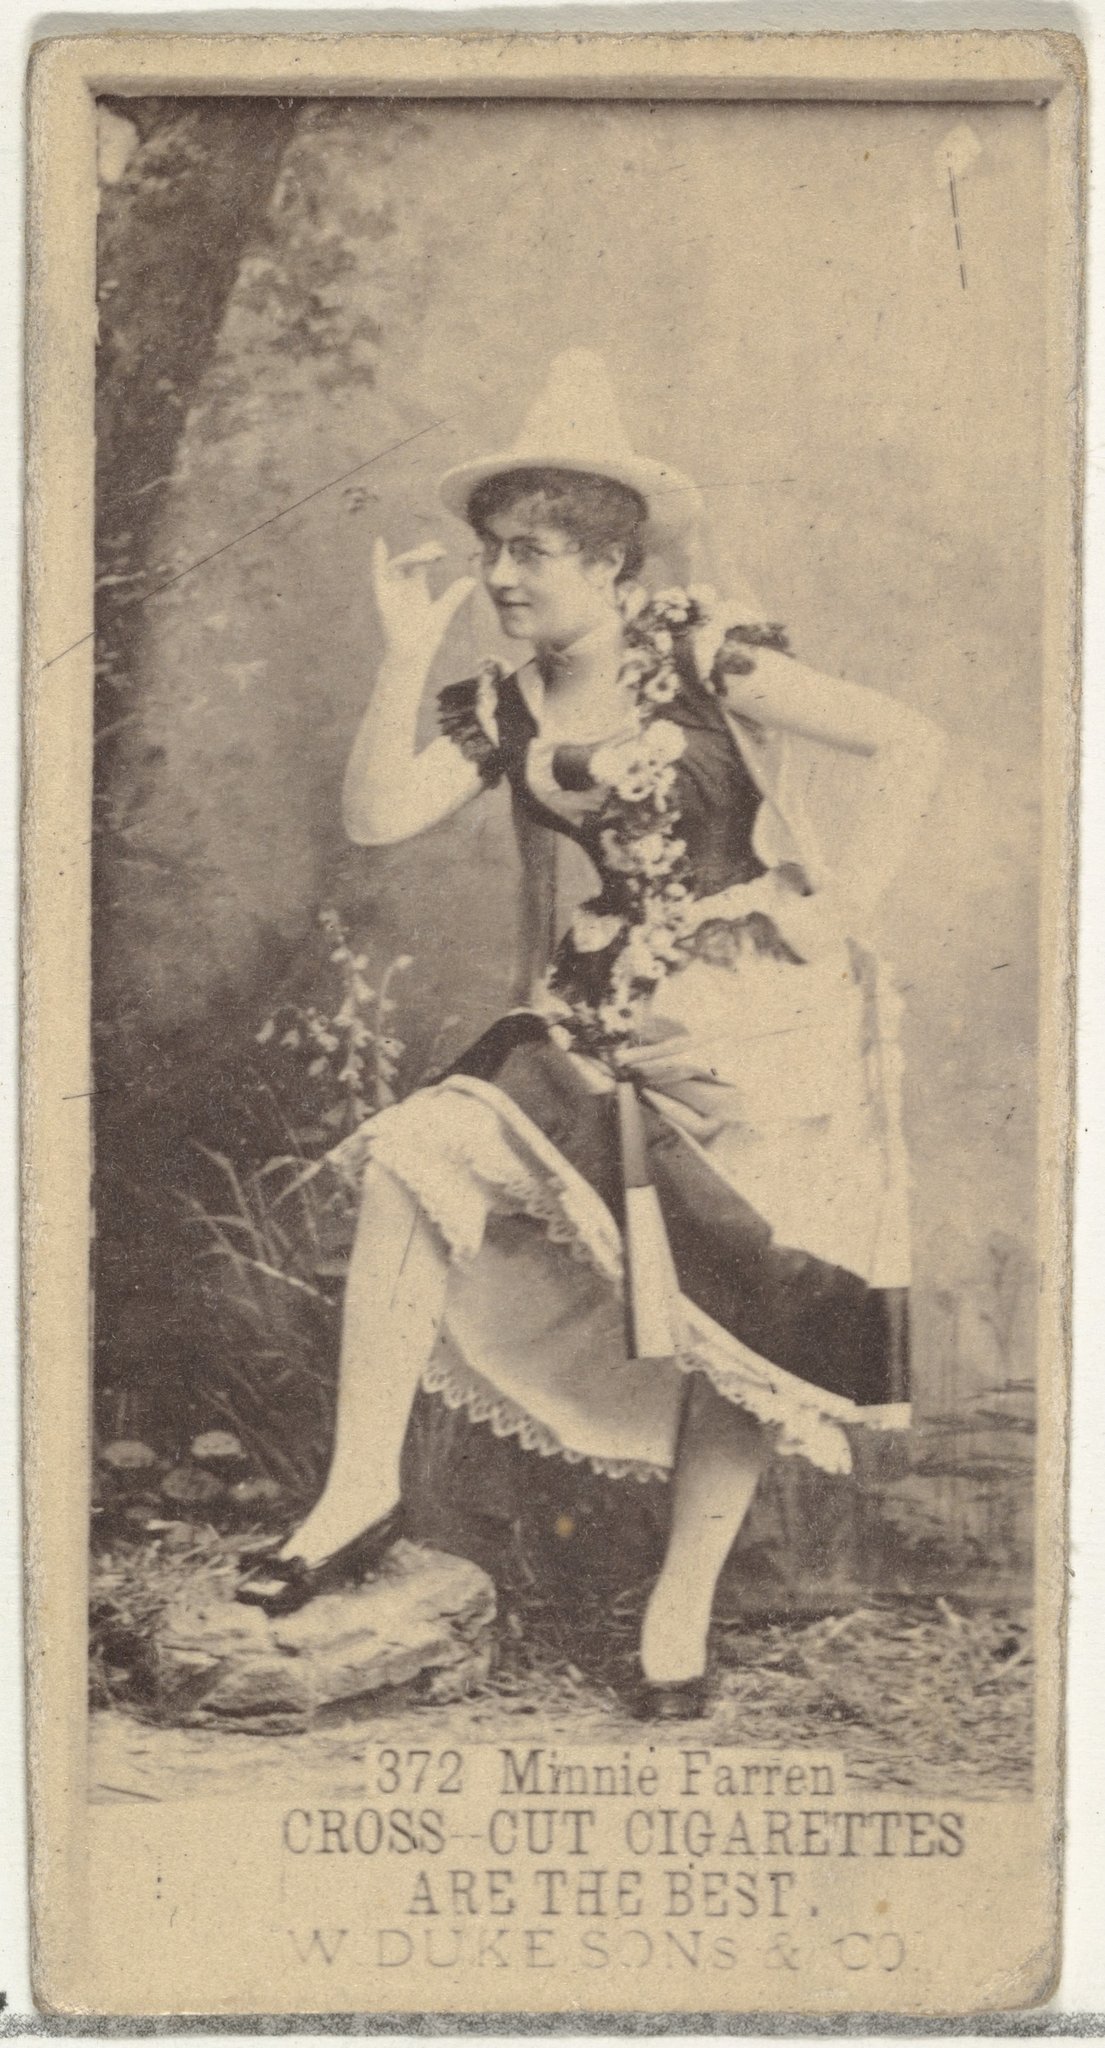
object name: photograph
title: Card Number 372, Minnie Farren, from the Actors and Actresses series (N145-3) issued by Duke Sons & Co. to promote Cross Cut Cigarettes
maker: w. duke, sons & co.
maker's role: publisher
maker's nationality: american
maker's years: 1870-1920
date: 1880-1889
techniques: albumen silver print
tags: portraits,women,actresses